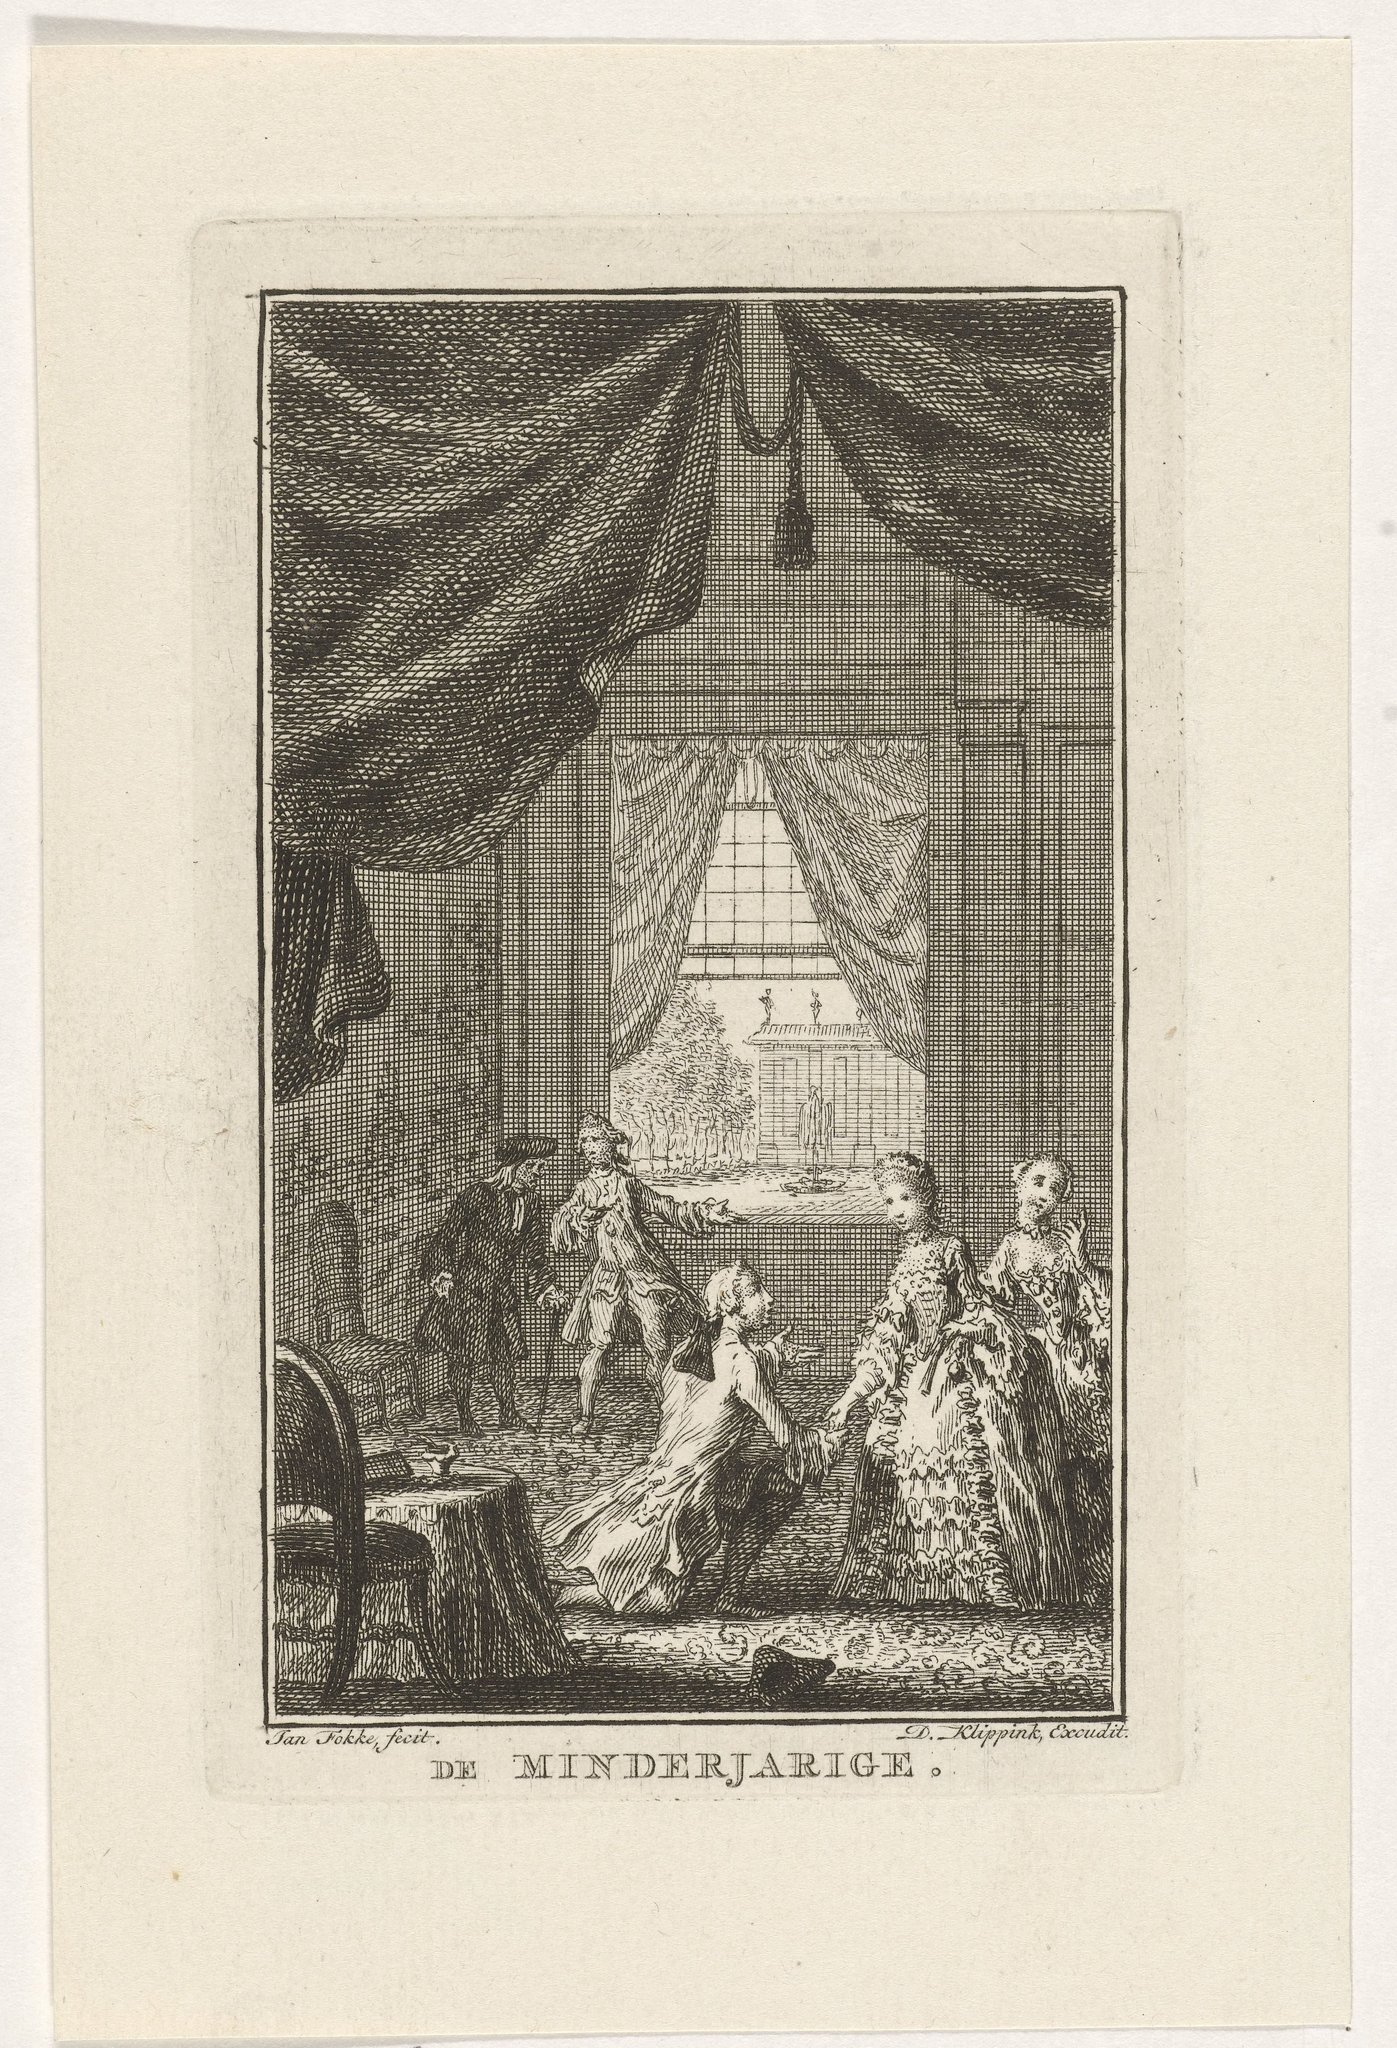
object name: print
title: Jongeman knielt voor meisje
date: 1758-1812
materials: paper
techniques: etching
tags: kneeling figure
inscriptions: collector's mark: Lugt 2228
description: In een kamer knielt een jongman voor een meisje. Deze prent is mogelijk vervaardigd voor het blijspel "De minderjarige" (1758) van Jan Jacob Hartsinck.